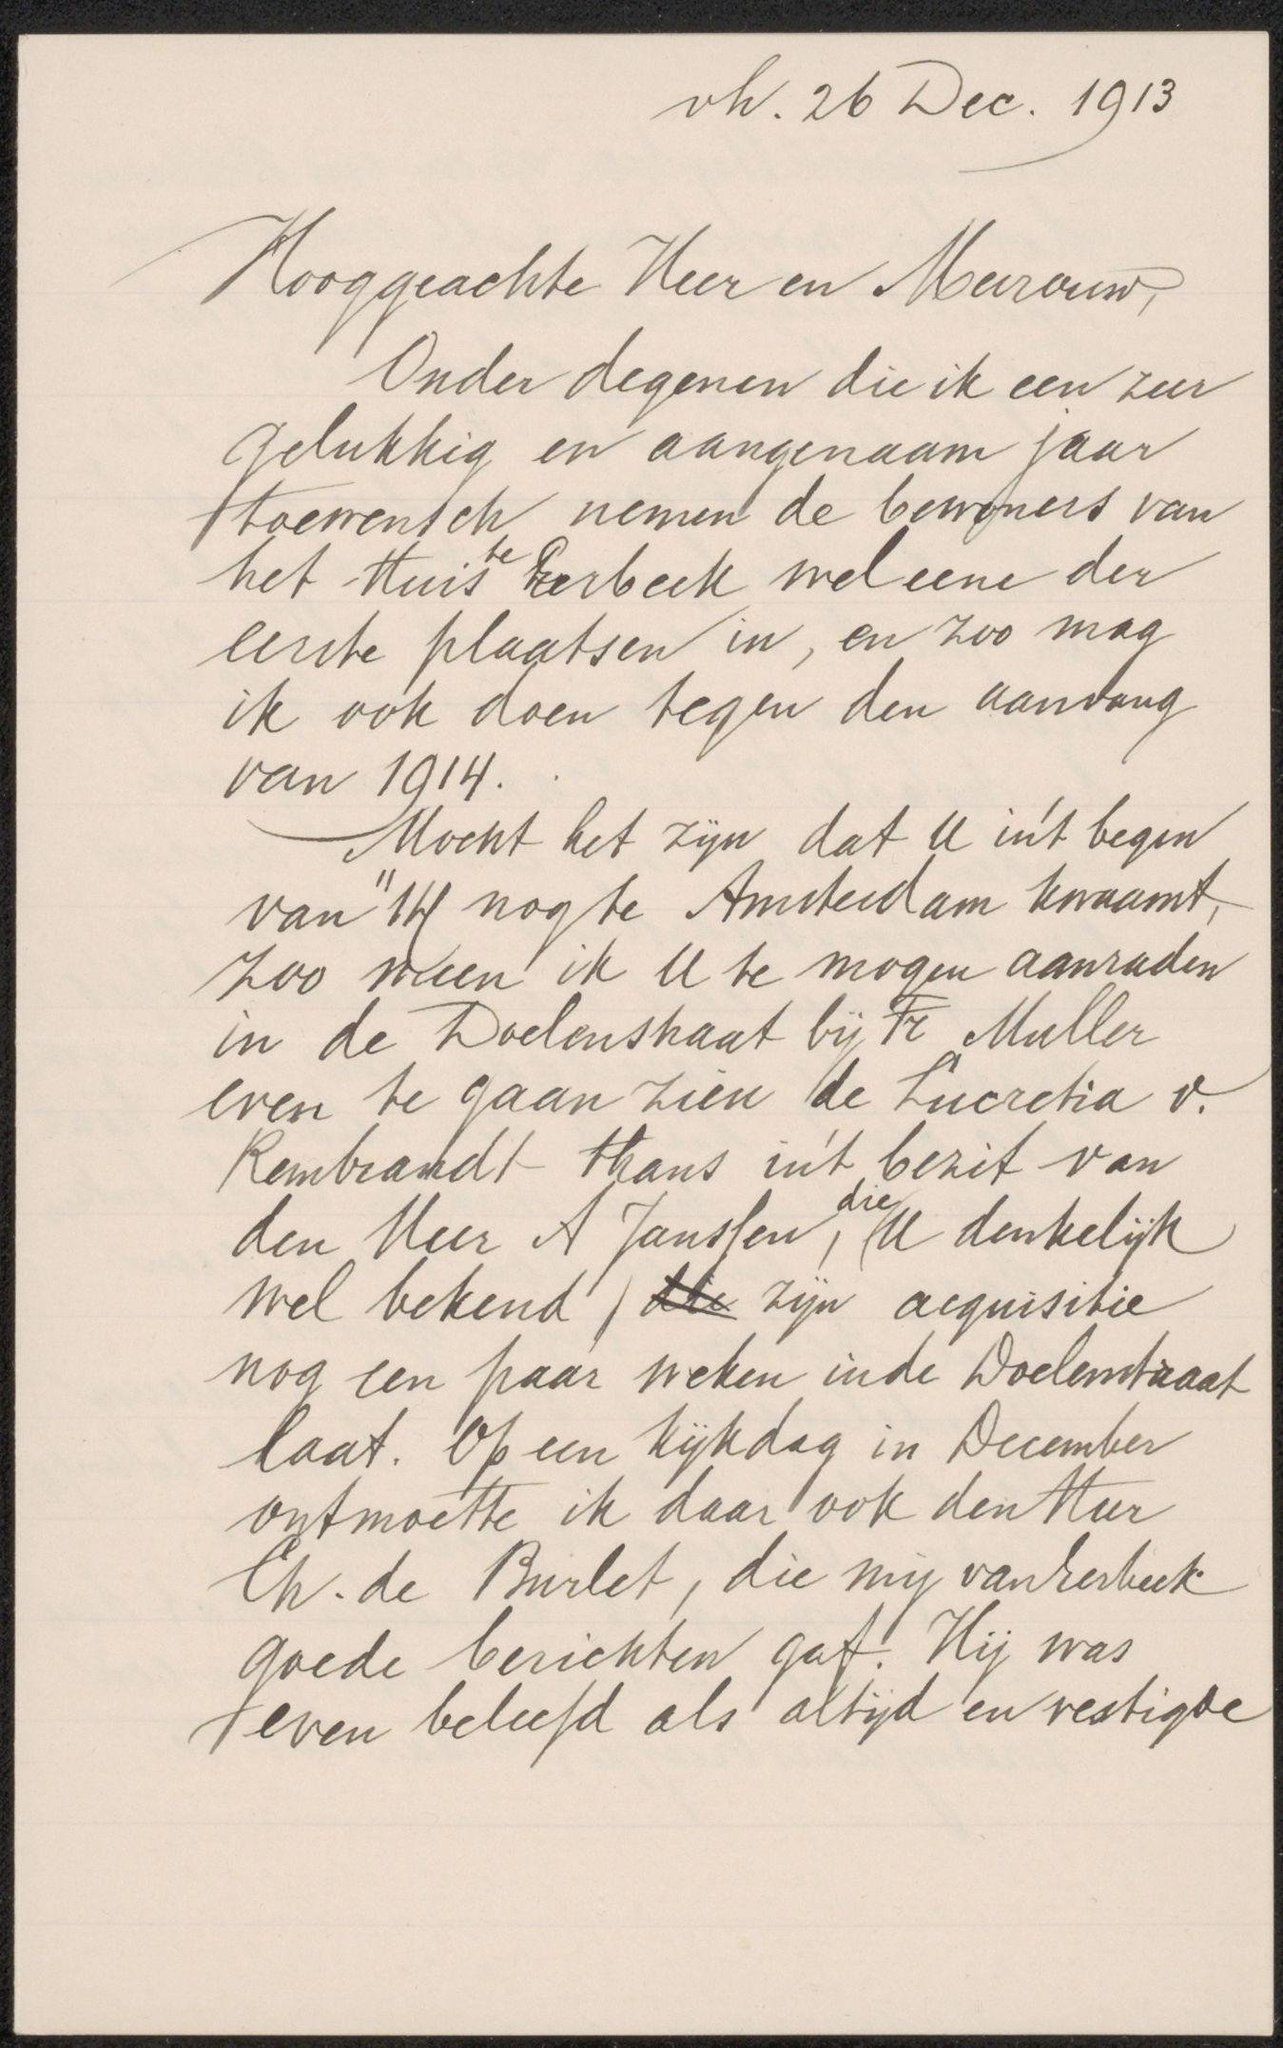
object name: letter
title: Brief aan Max Wilhelm Carl Weber en Anne Antoinette Weber-Van Bosse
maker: august allebé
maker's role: draughtsman, print maker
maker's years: 1838-1927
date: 1913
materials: ink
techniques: pen, writing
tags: charles albert de burlet, amsterdam, the hague, painter, print maker, draughtsman, jozef israëls, lourens alma tadema, anne antoinette weber-van bosse, leiden, rembrandt van rijn, rijksmuseum amsterdam, art trade, art shop, the graphic arts, painting (including book-illumination, miniature-painting)